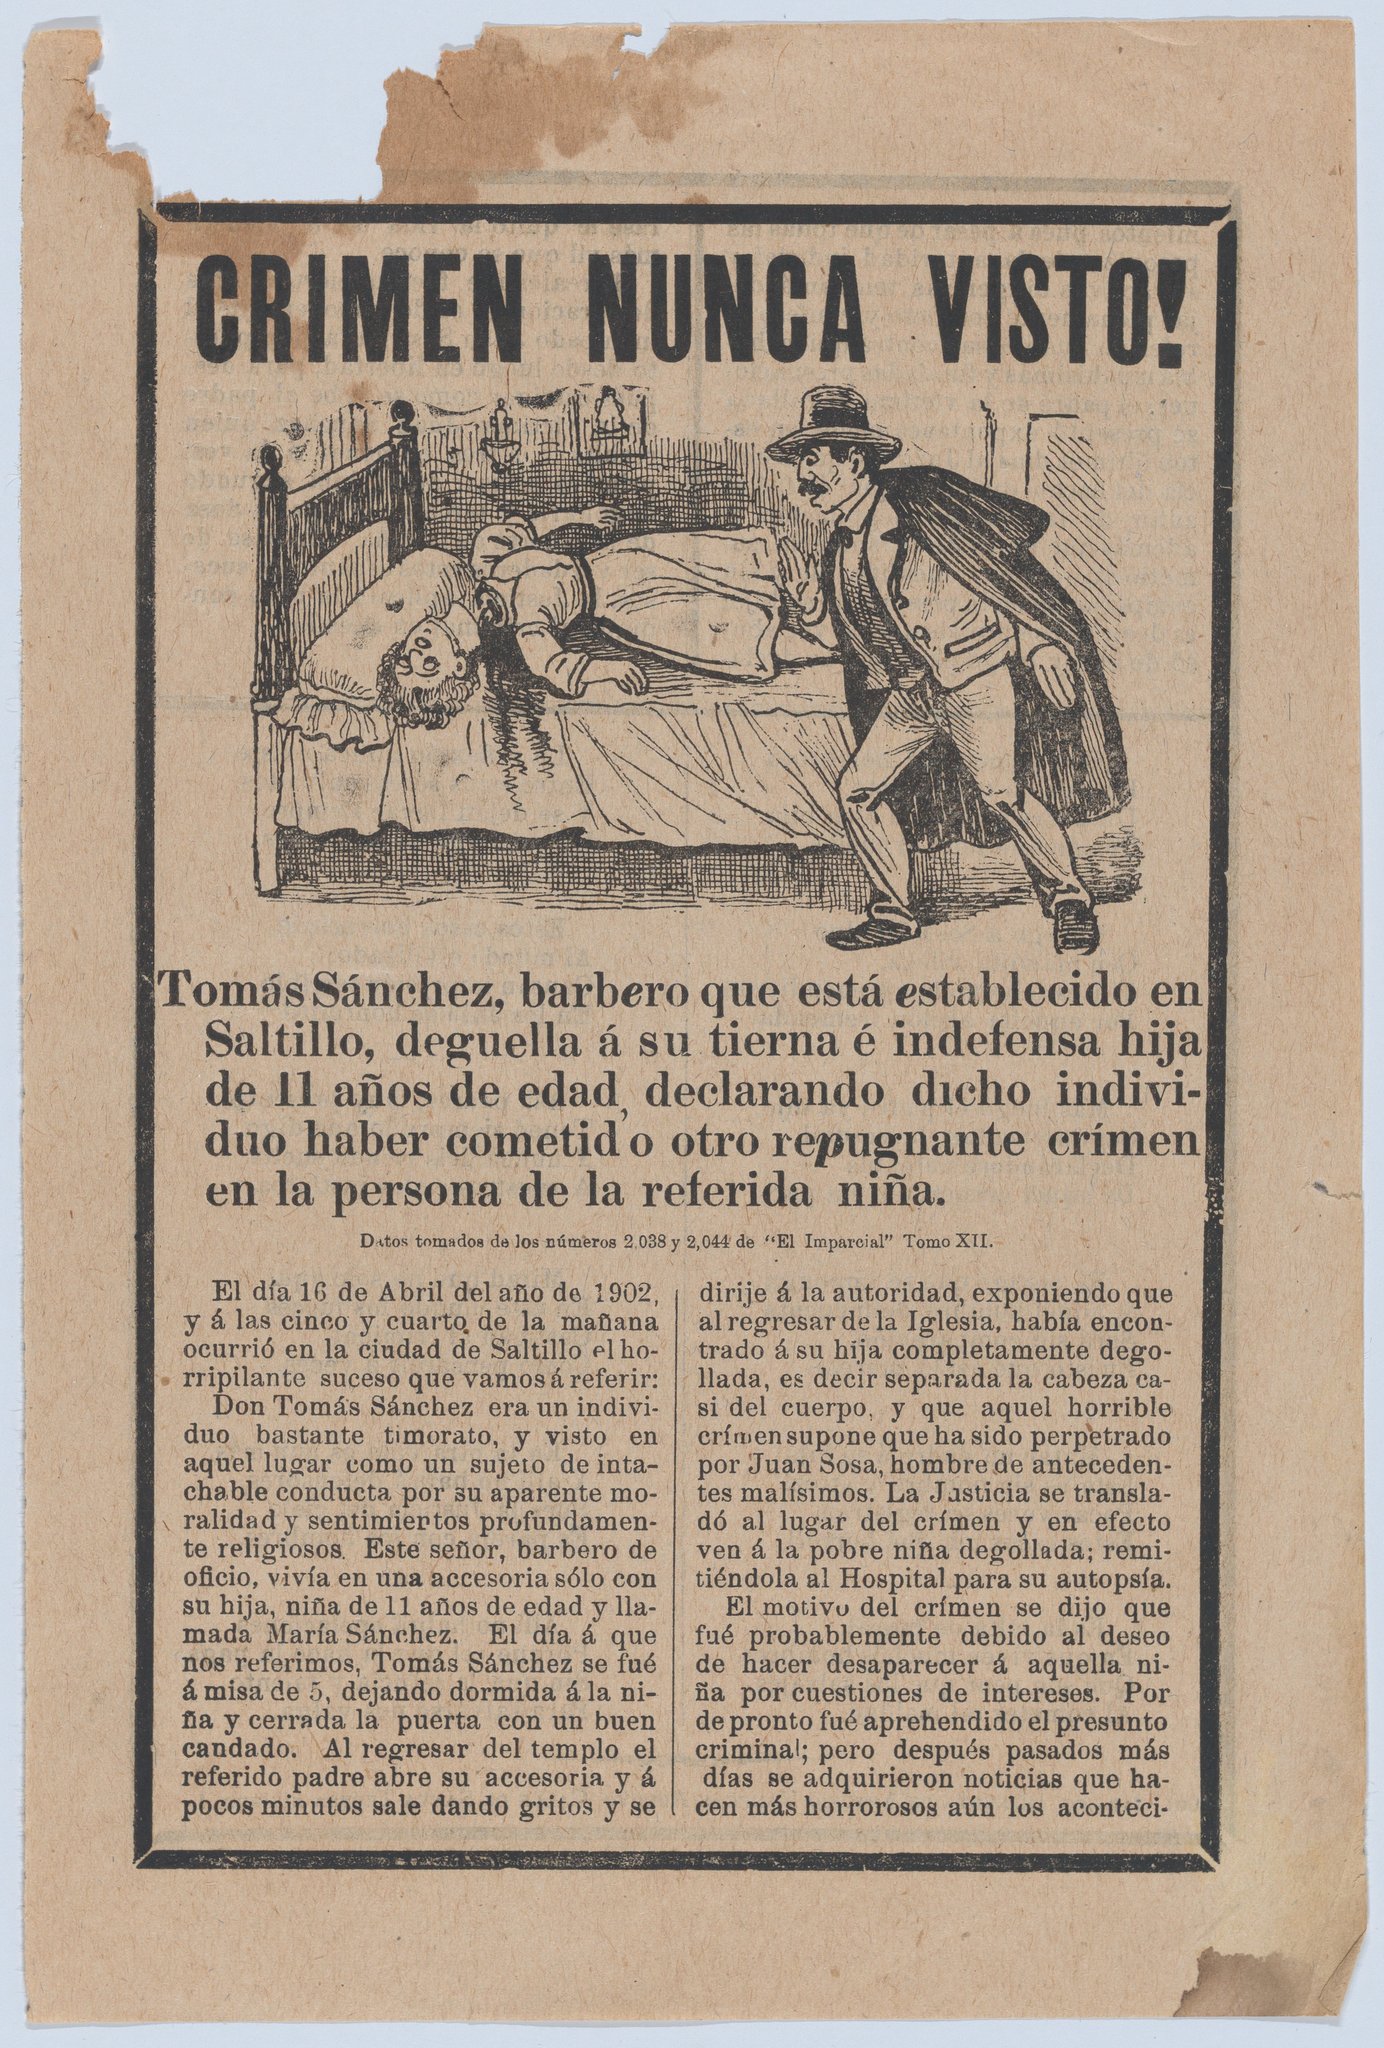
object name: print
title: Broadsheet relating to a young girl who was beheaded while her father Tomás Sánchez left her at home alone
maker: josé guadalupe posada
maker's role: artist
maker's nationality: mexican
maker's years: 1852-1913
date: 1902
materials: paper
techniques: letterpress, lithography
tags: girls,death,documents